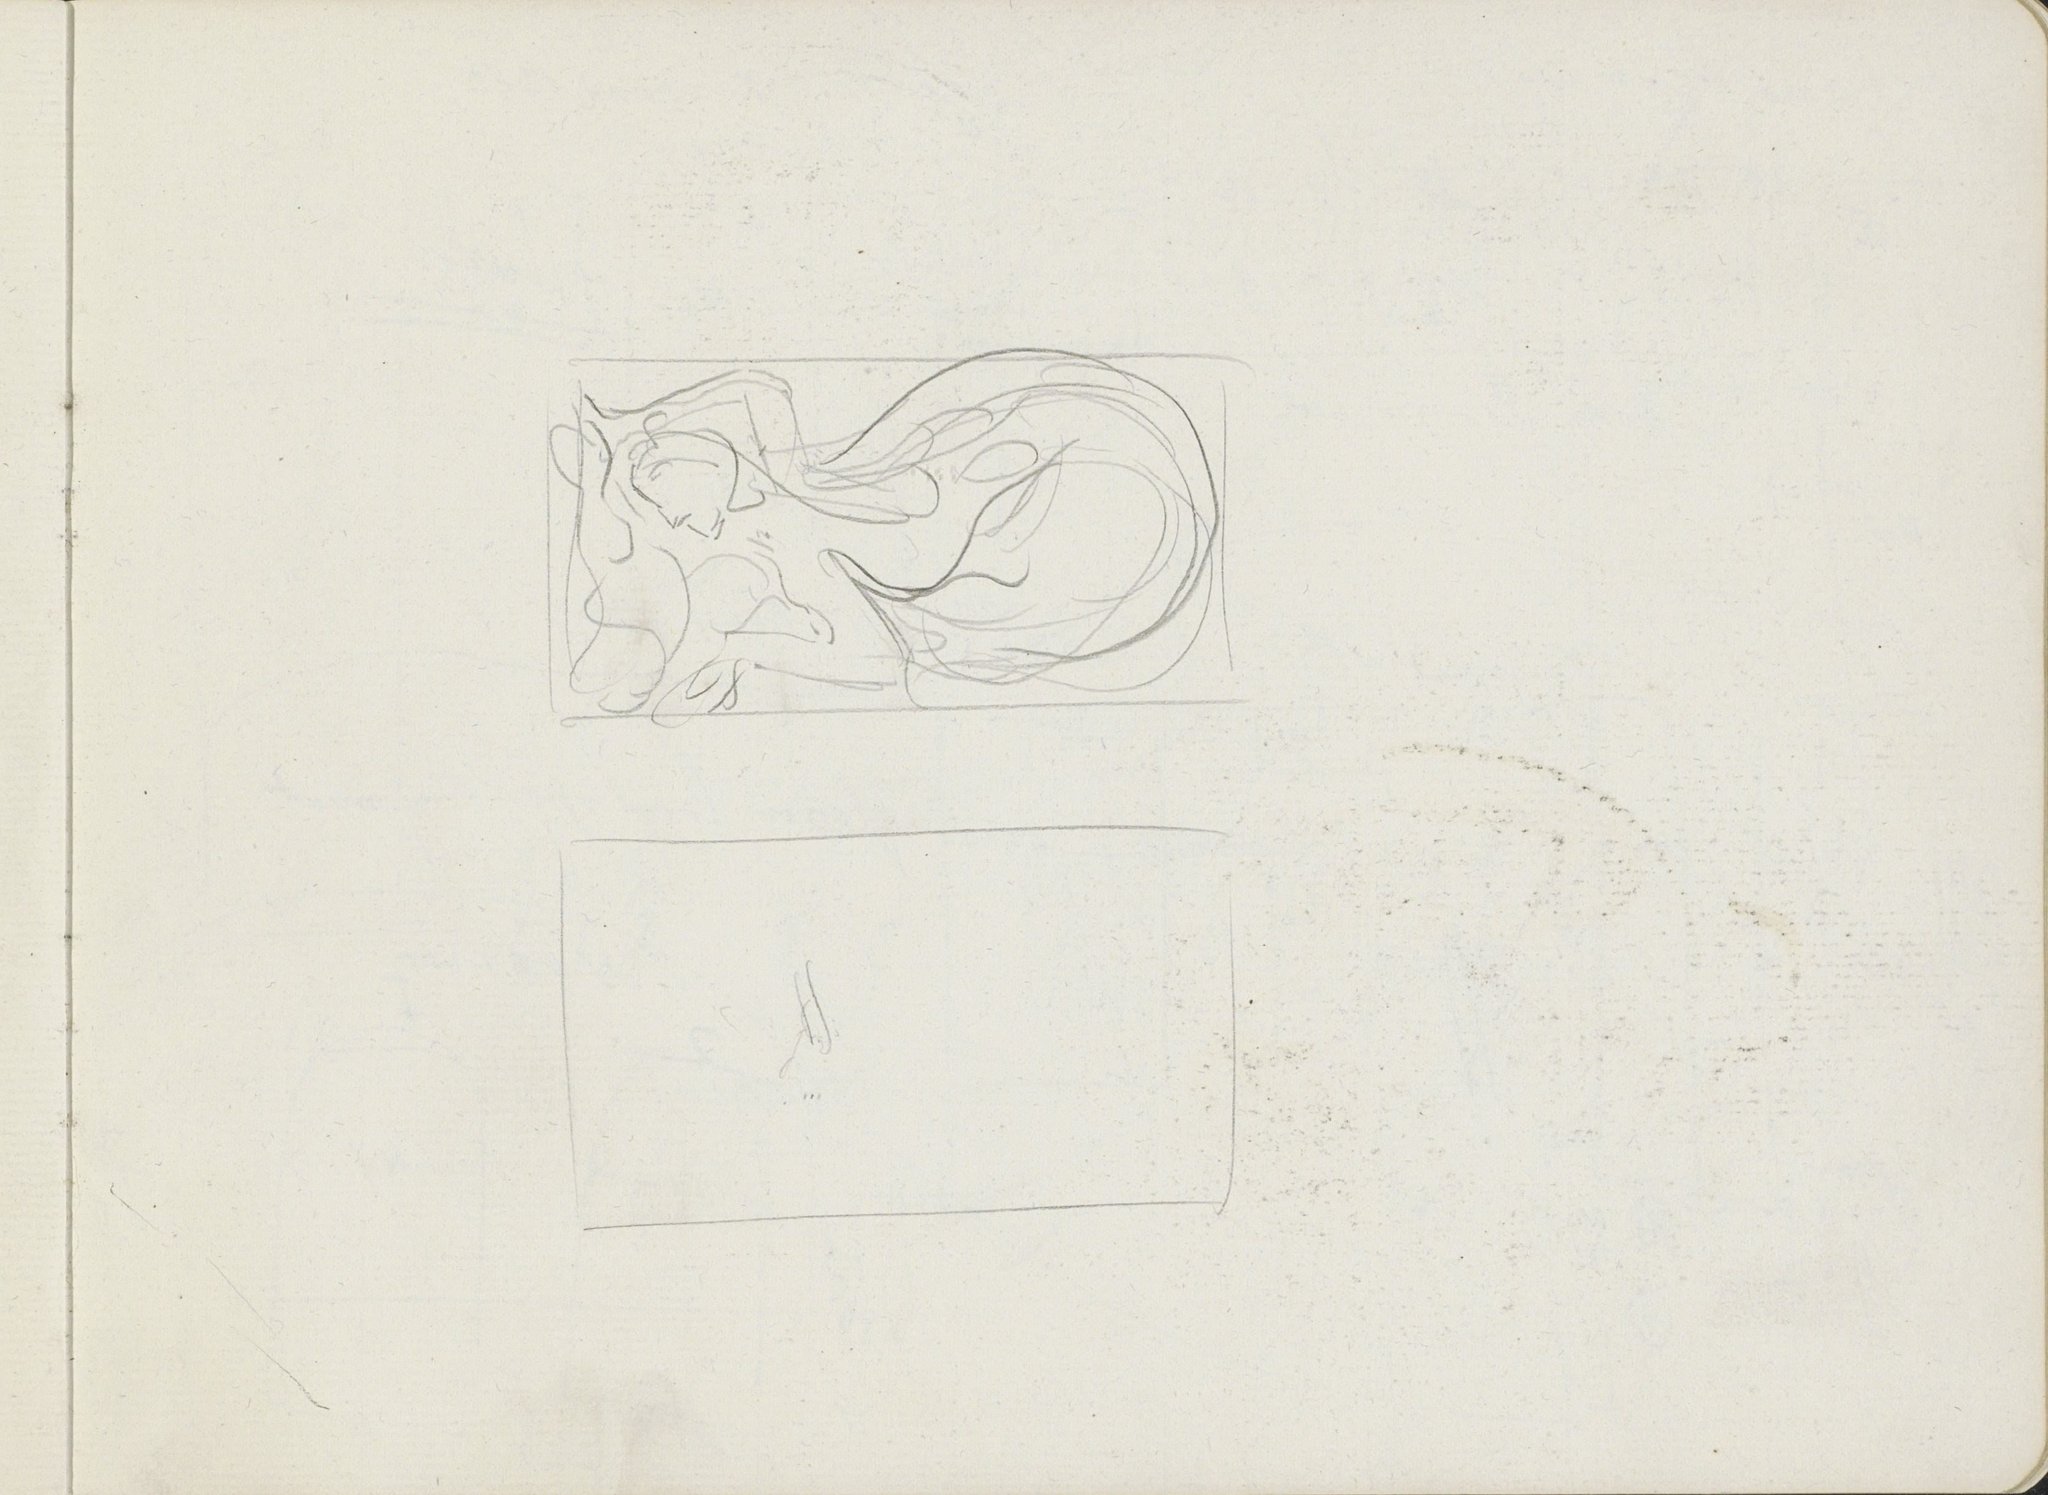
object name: sketchbook leaf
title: Ornament met een zeemeermin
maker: carel adolph lion cachet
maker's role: draughtsman, print maker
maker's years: 1864-1945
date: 1905-1910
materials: paper, pencil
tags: ornaments ~ art, merman - aa - mermaid, siren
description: Blad 8 recto uit een schetsboek met 27 bladen.